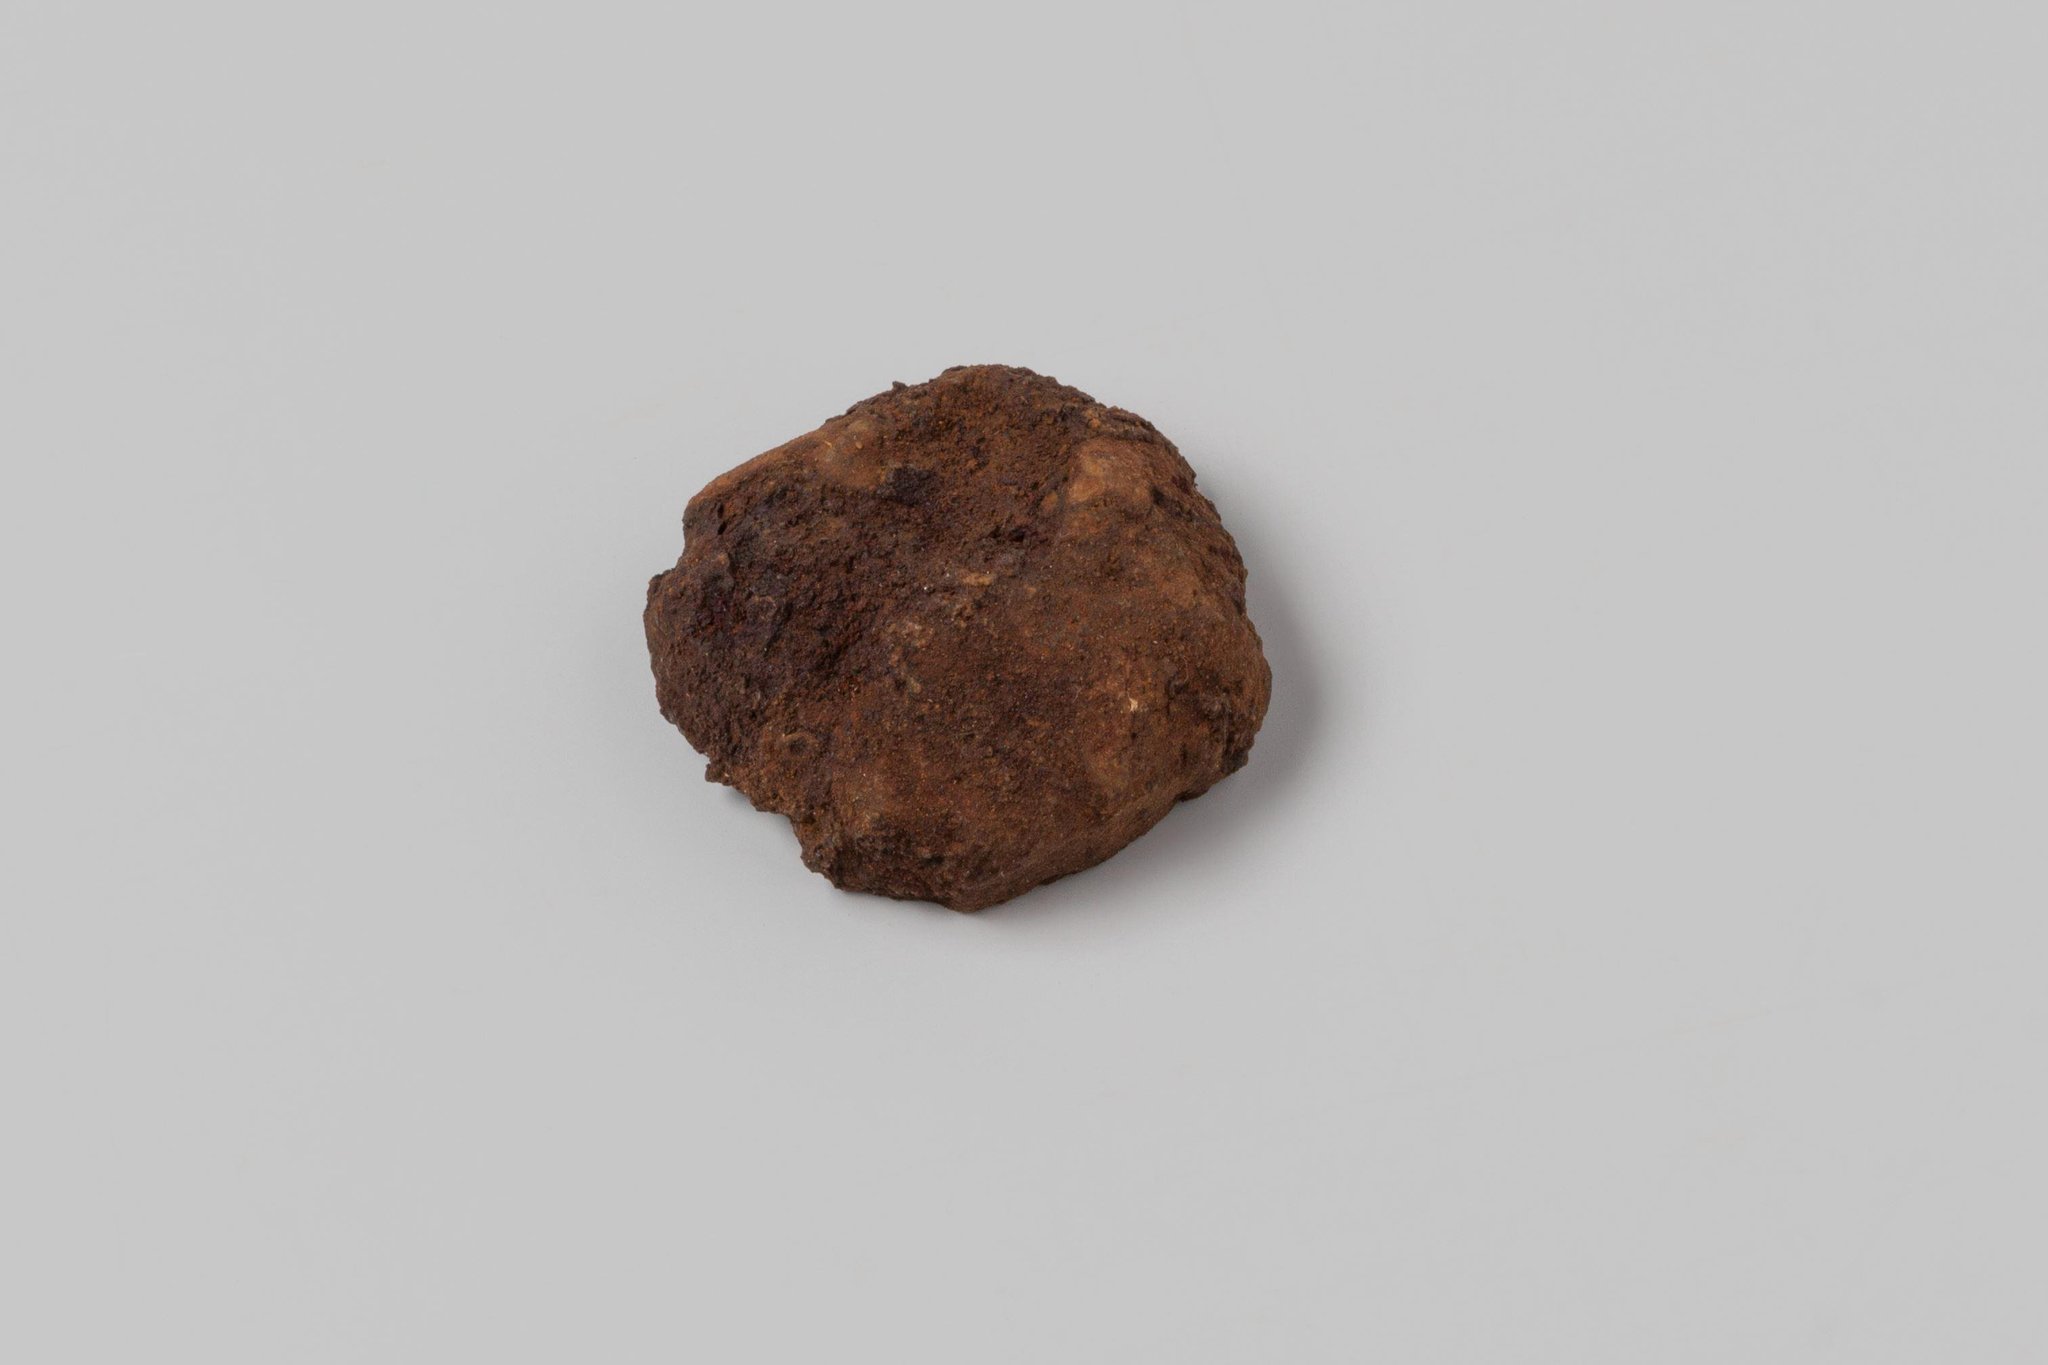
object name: fragment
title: Fragment ijzer uit het wrak van de Oost-Indiëvaarder Hollandia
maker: Anonymous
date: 1700-1743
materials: iron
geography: netherlands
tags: verenigde oostindische compagnie, hollandia (schip), annet